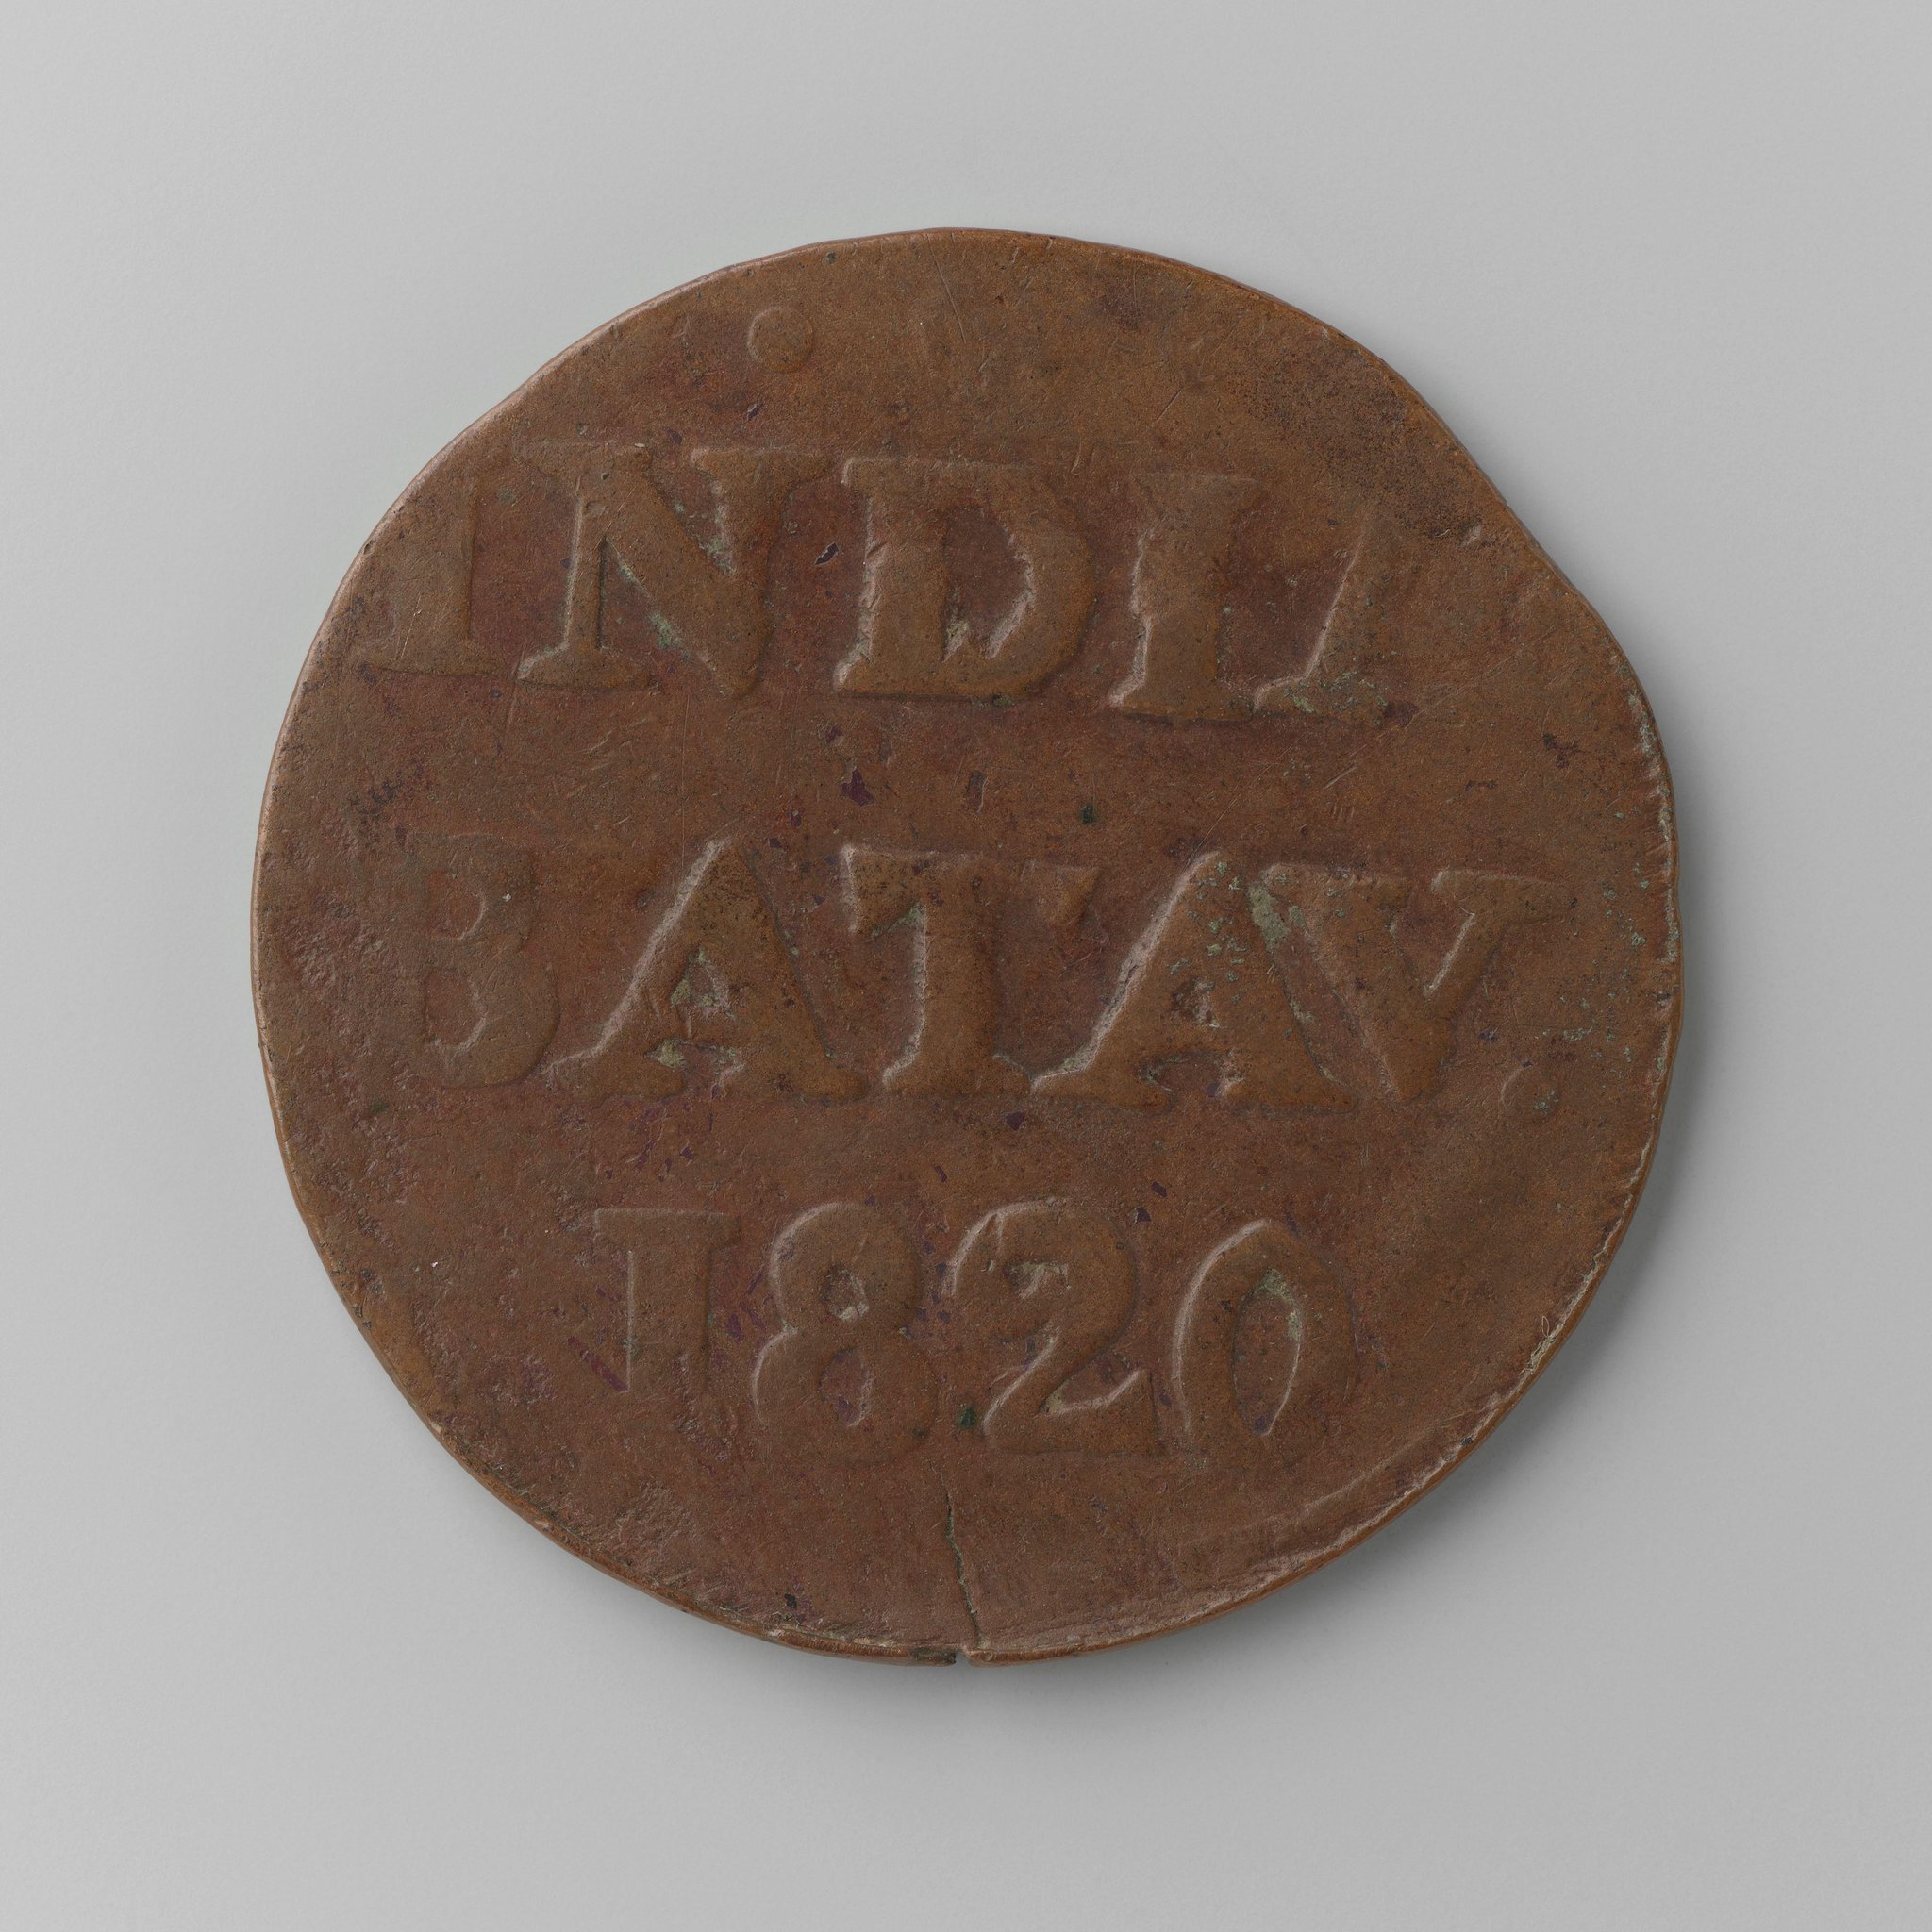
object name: coin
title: ½ stuiver van Nederlands Indië, 1820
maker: william i of the netherlands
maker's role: koning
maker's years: 1772-1843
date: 1820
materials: copper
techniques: striking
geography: surabaya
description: Koperen munt. Voorzijde: tussen waarde-aanduiding ½ St. gekroond generaliteitswapenschild. Keerzijde: tweeregelig opschrift, waarboven muntteken en waaronder jaartal. Gladde rand.